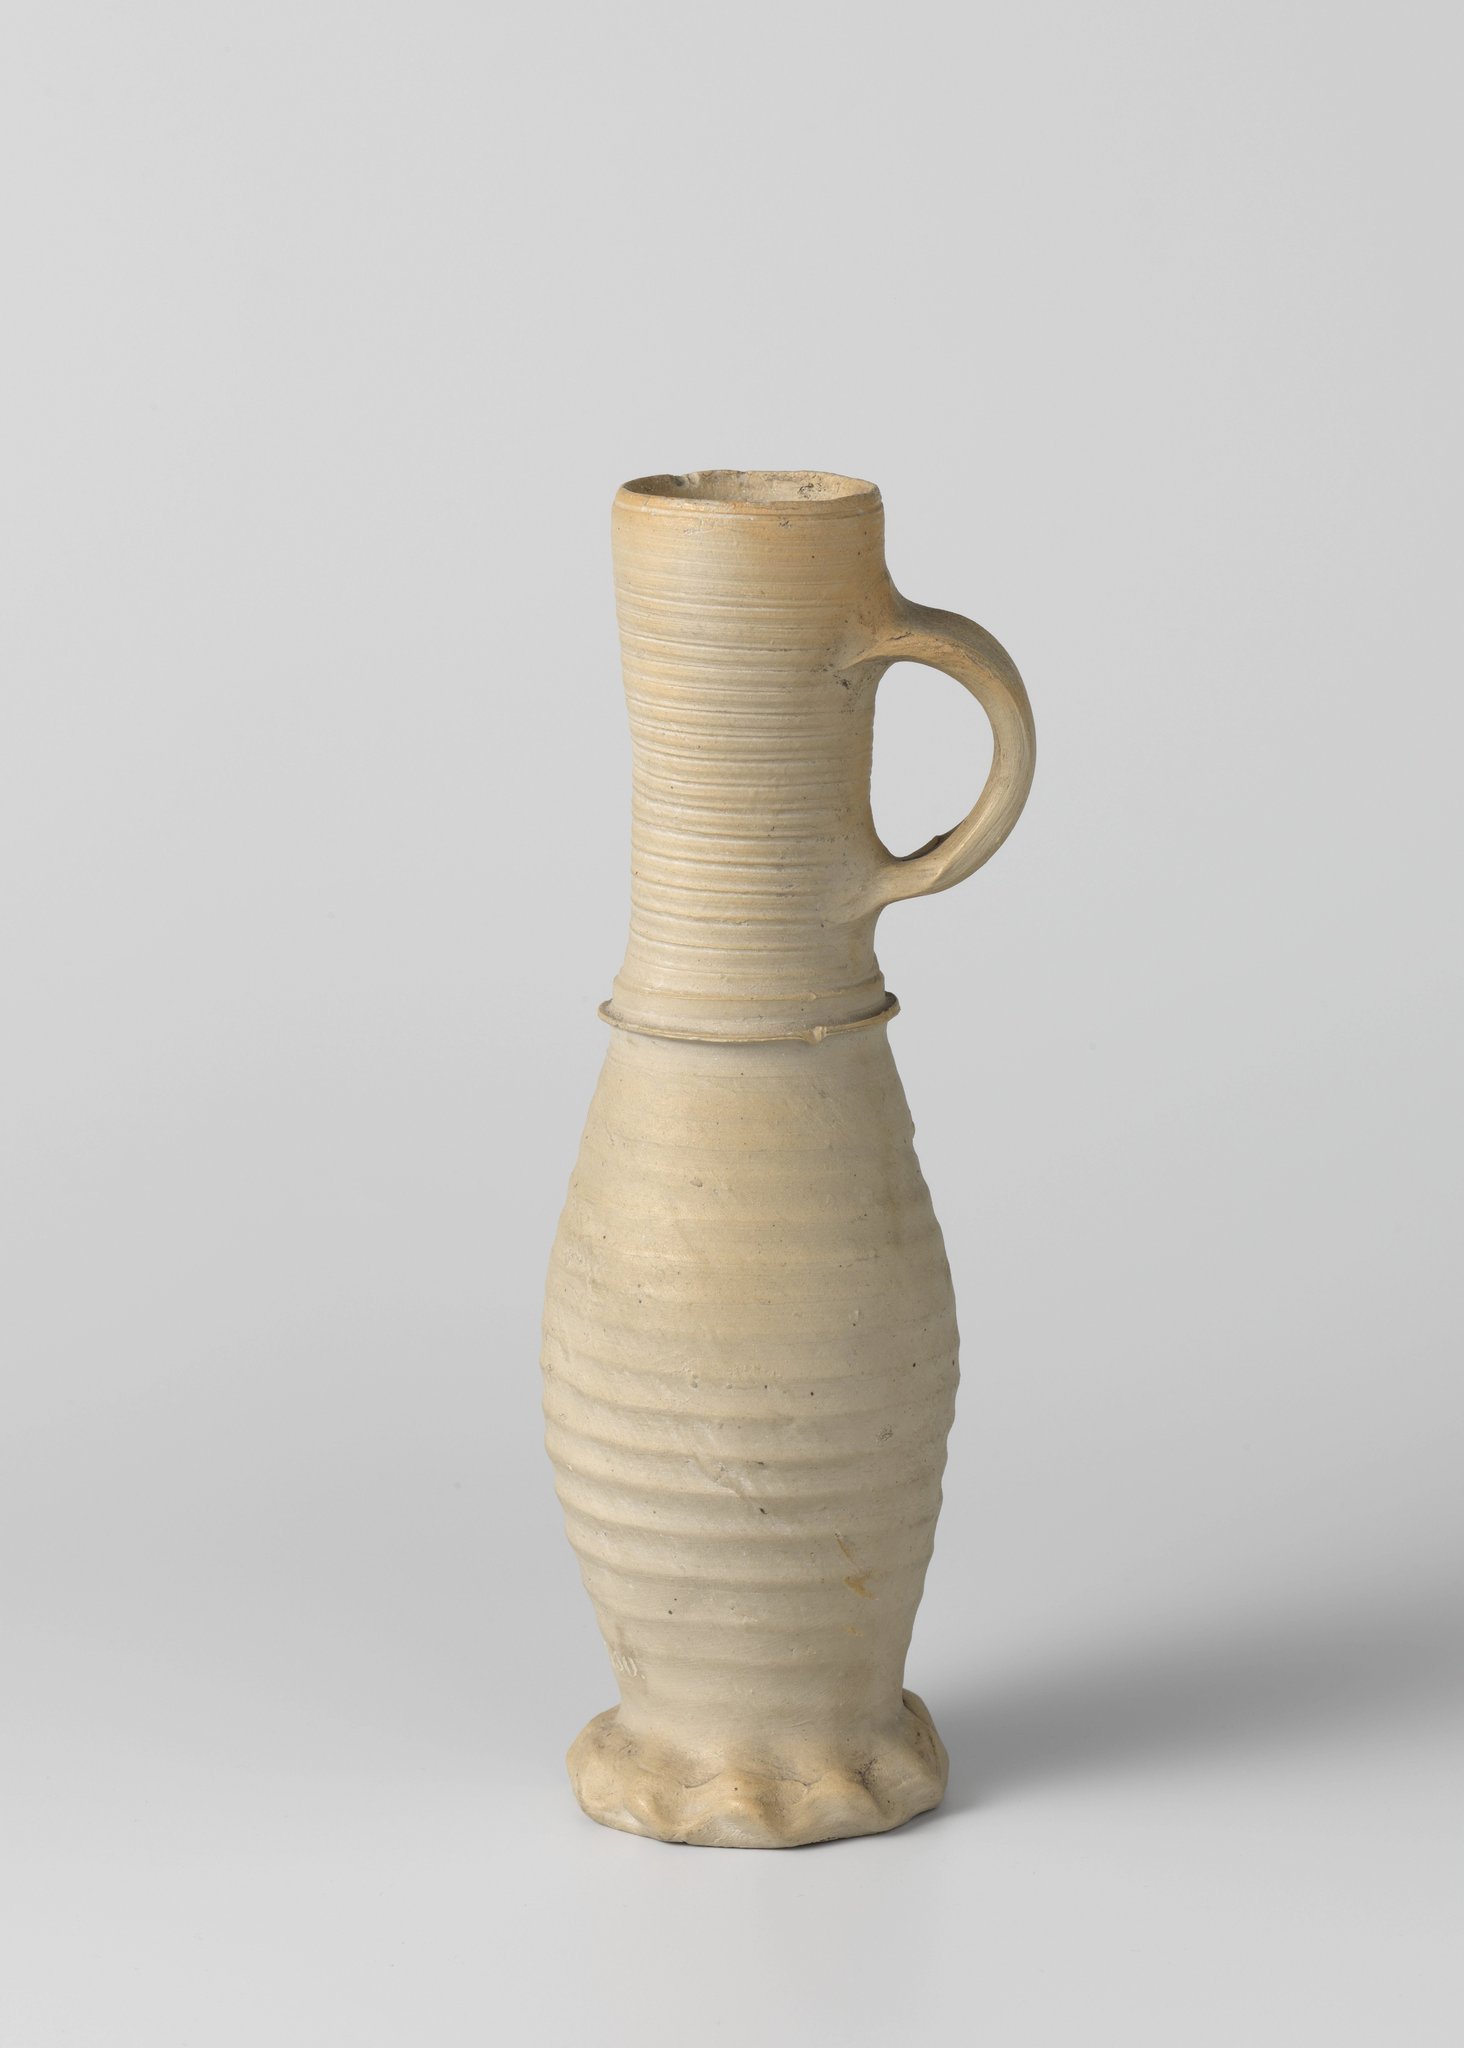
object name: jacobakan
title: Jug or 'Jacobakan'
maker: Anonymous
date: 1300-1499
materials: glaze, stoneware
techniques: firing, forming, turning, vitrification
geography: siegburg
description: Jug (Jakobakanne). Siegburg, c. 1450 - 1550.